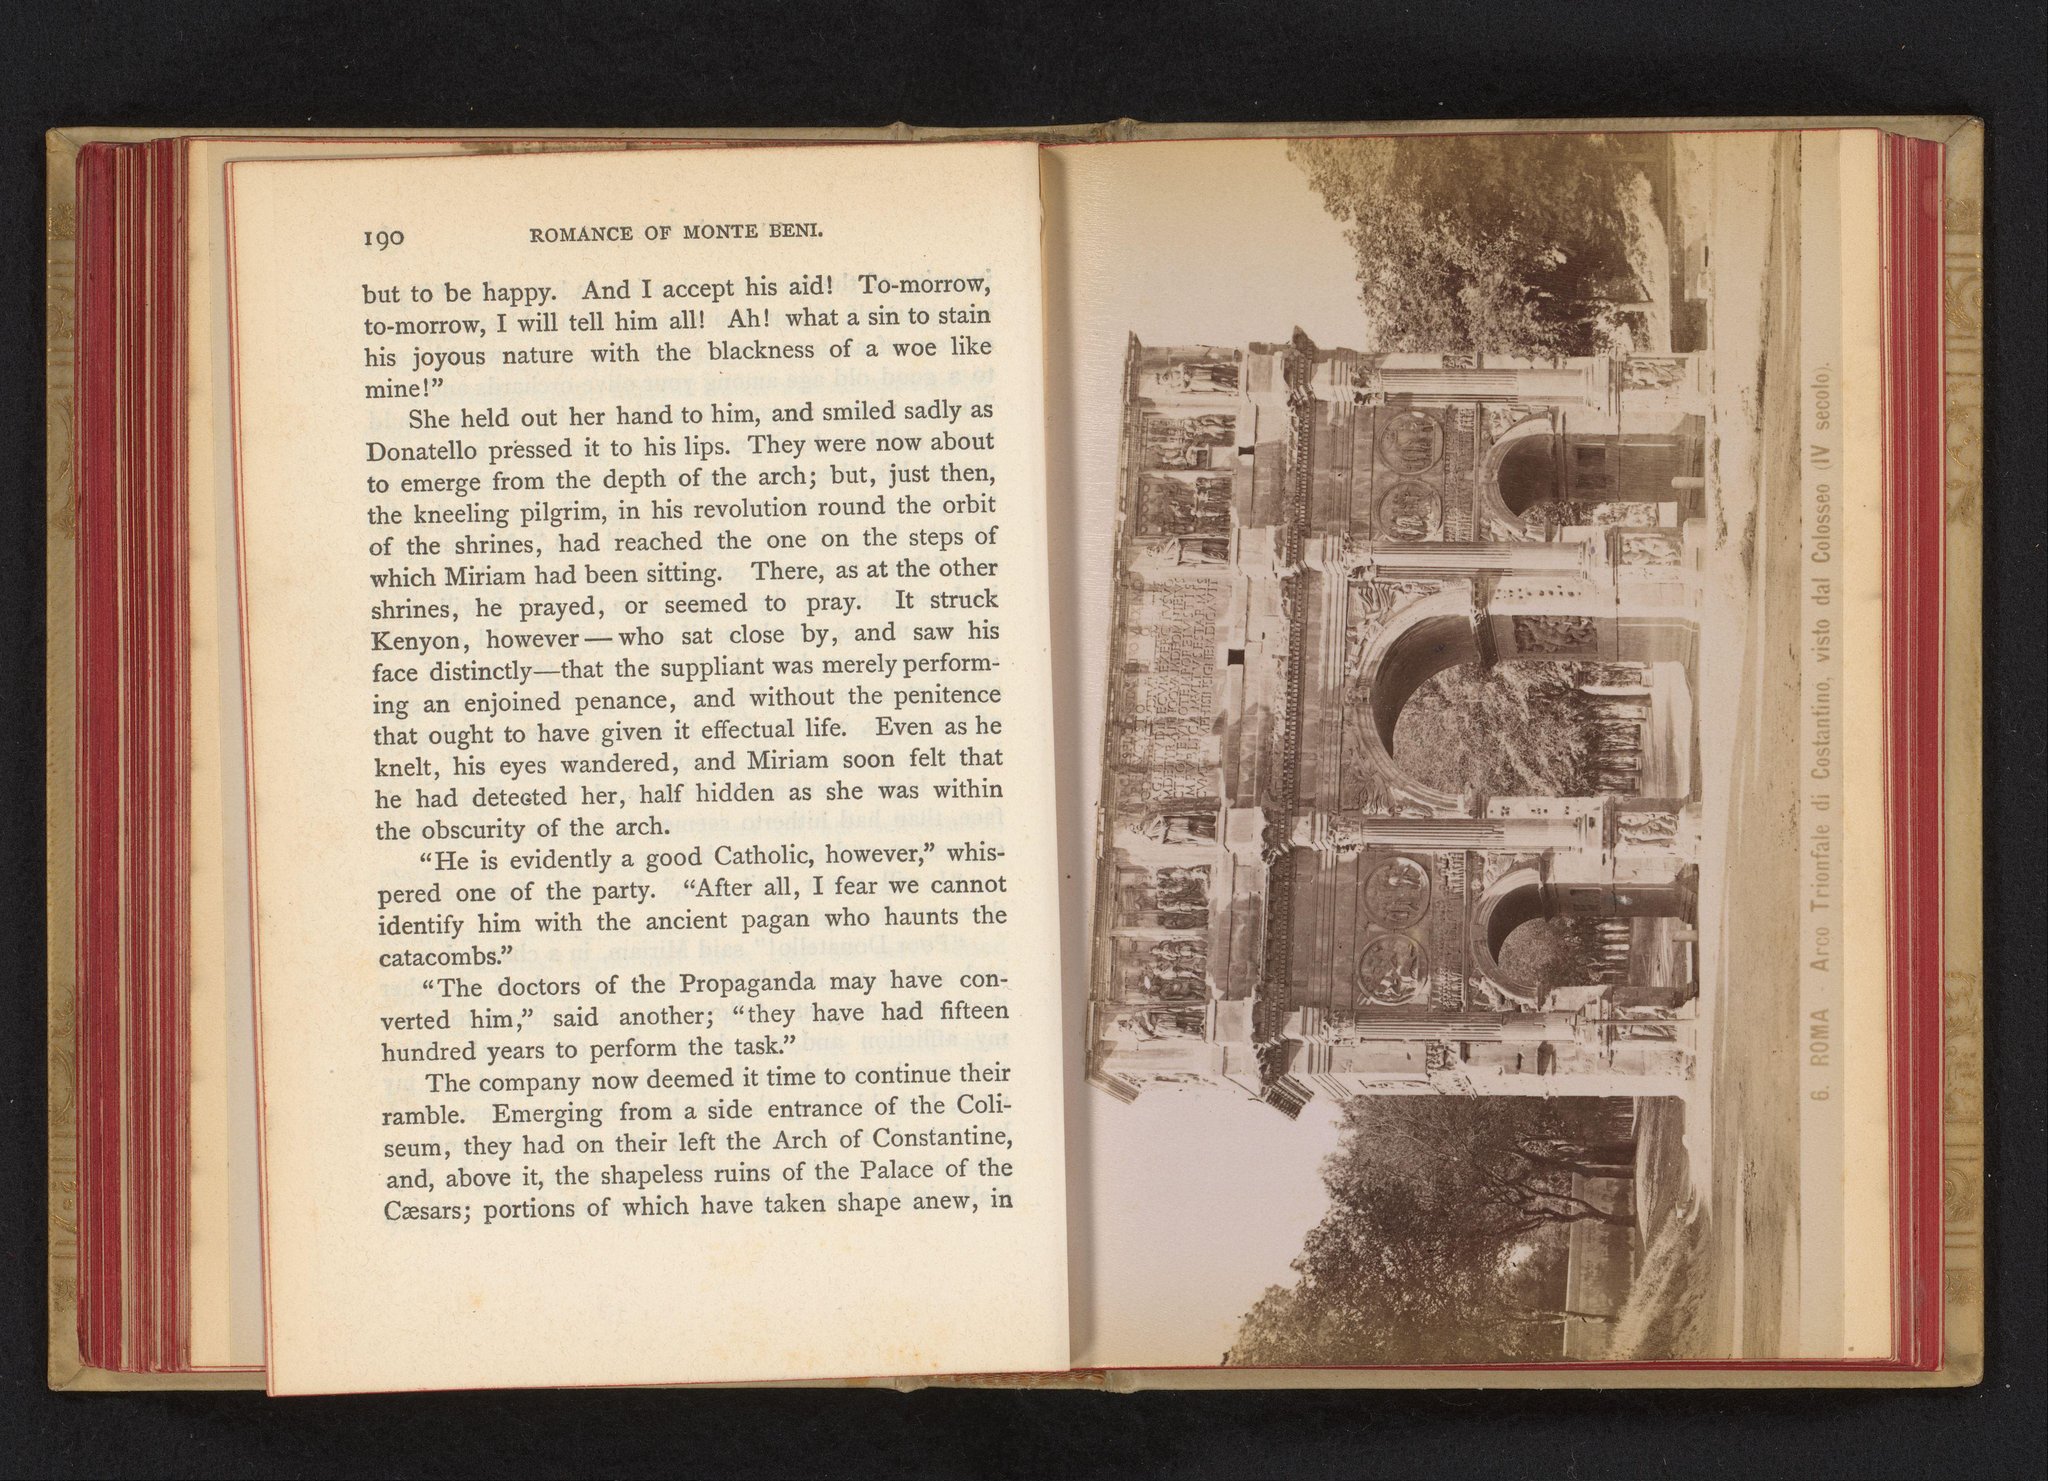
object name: page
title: Boog van Constantijn in Rome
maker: Anonymous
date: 1855-1860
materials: paper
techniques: albumen print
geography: rome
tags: triumphal arch, arch of constantine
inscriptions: number: ‘6.’